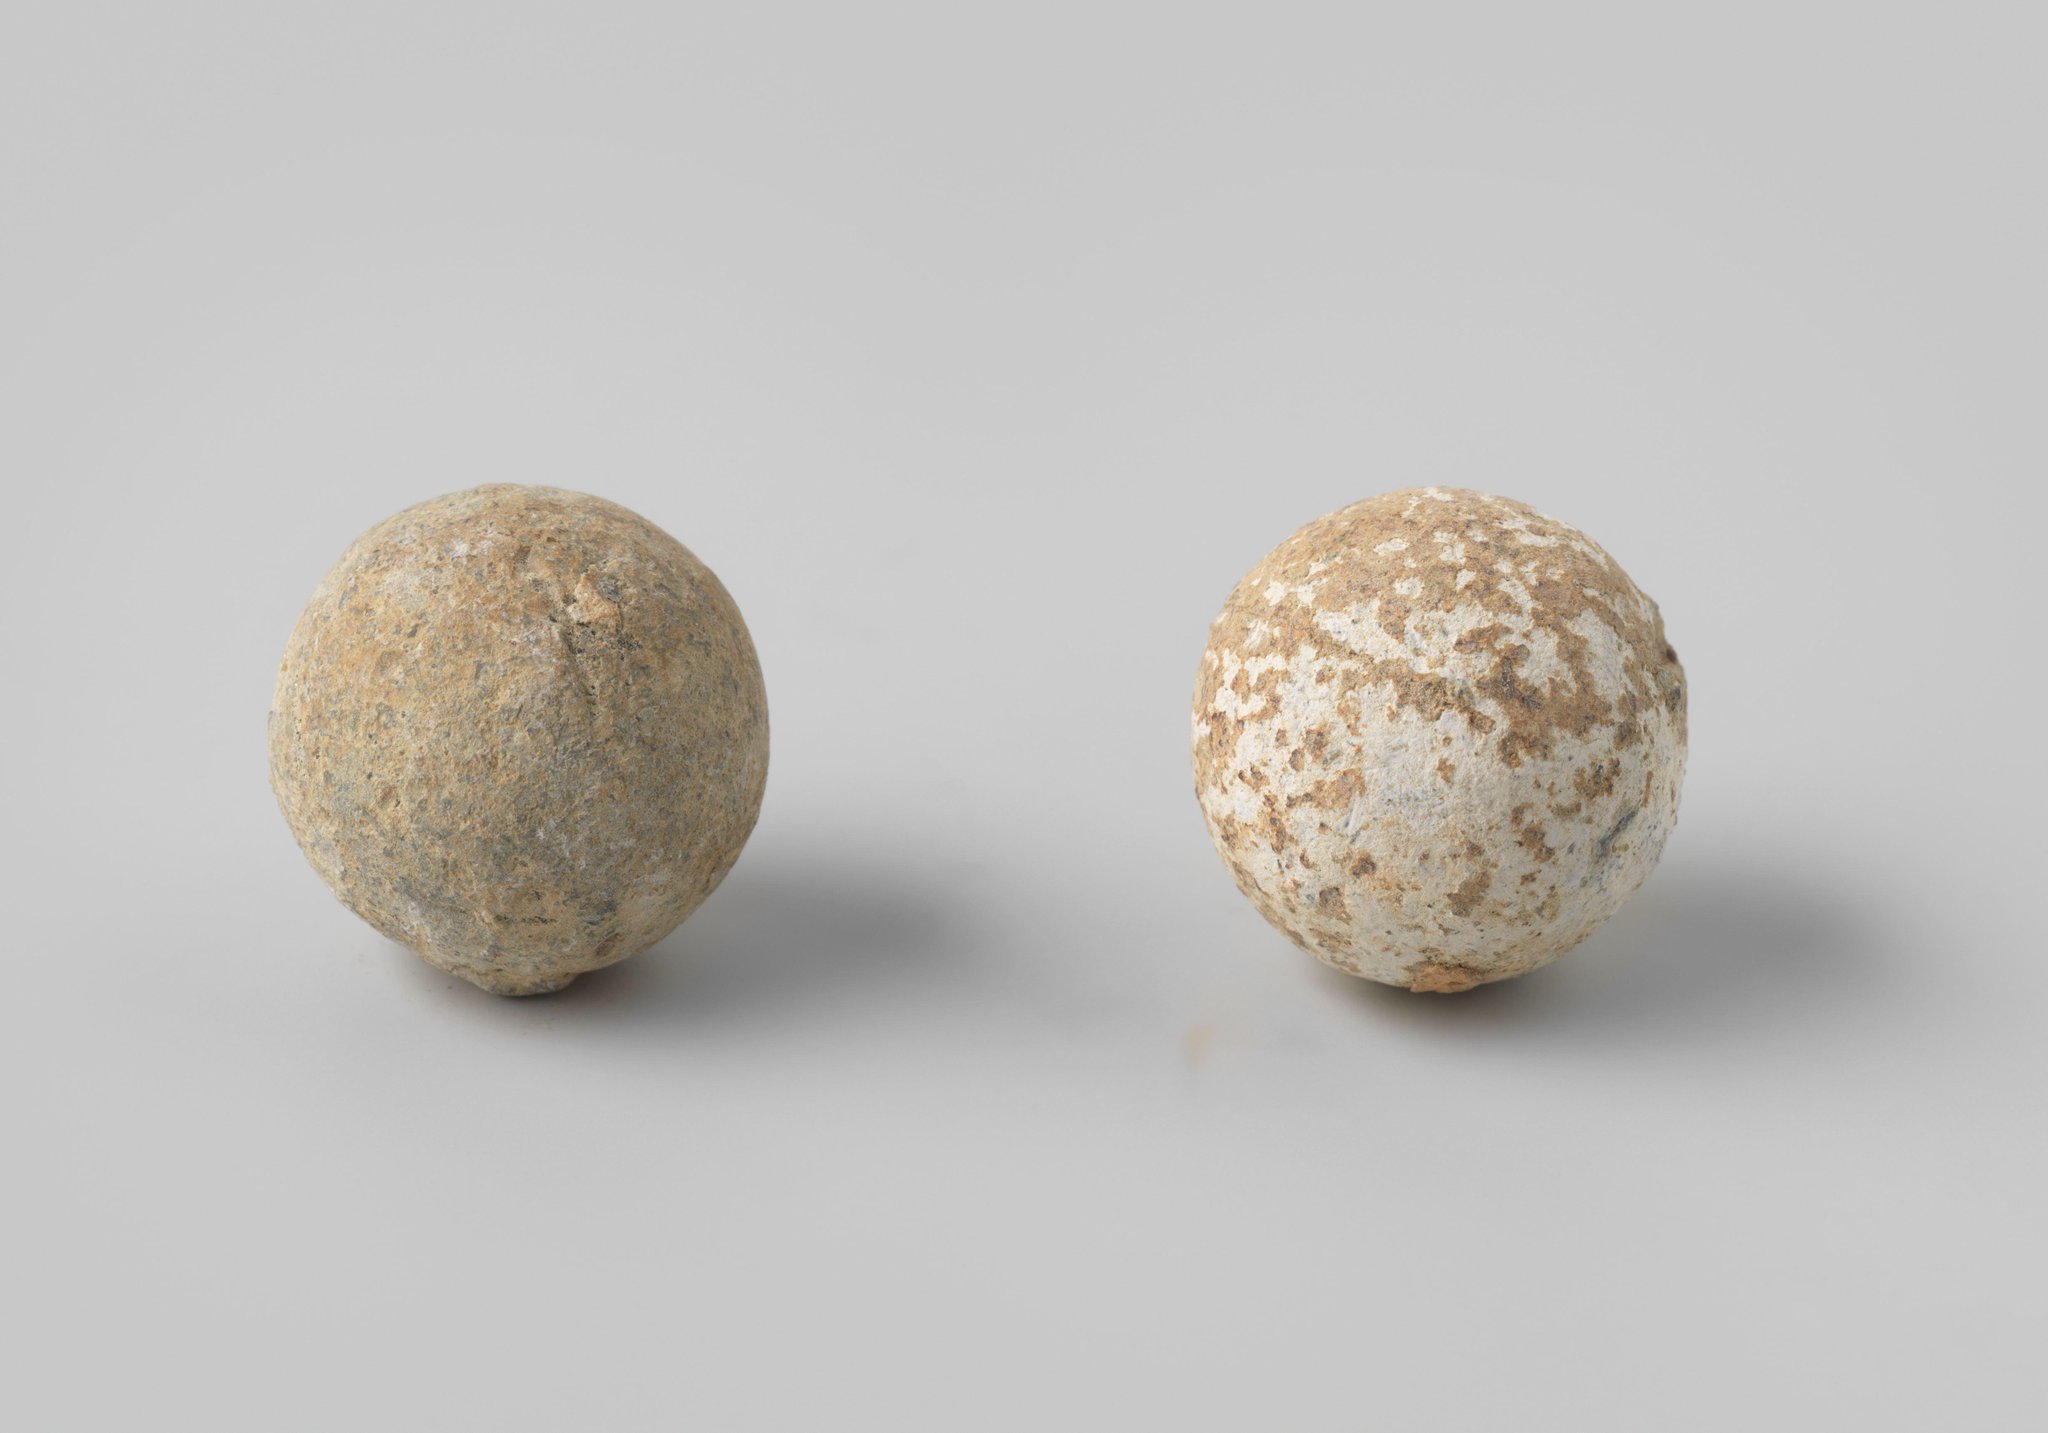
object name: musketkogel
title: Musketkogels uit het wrak van de Oost-Indiëvaarder Hollandia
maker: Anonymous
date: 1700-1743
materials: lead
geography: netherlands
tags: verenigde oostindische compagnie, hollandia (schip), annet